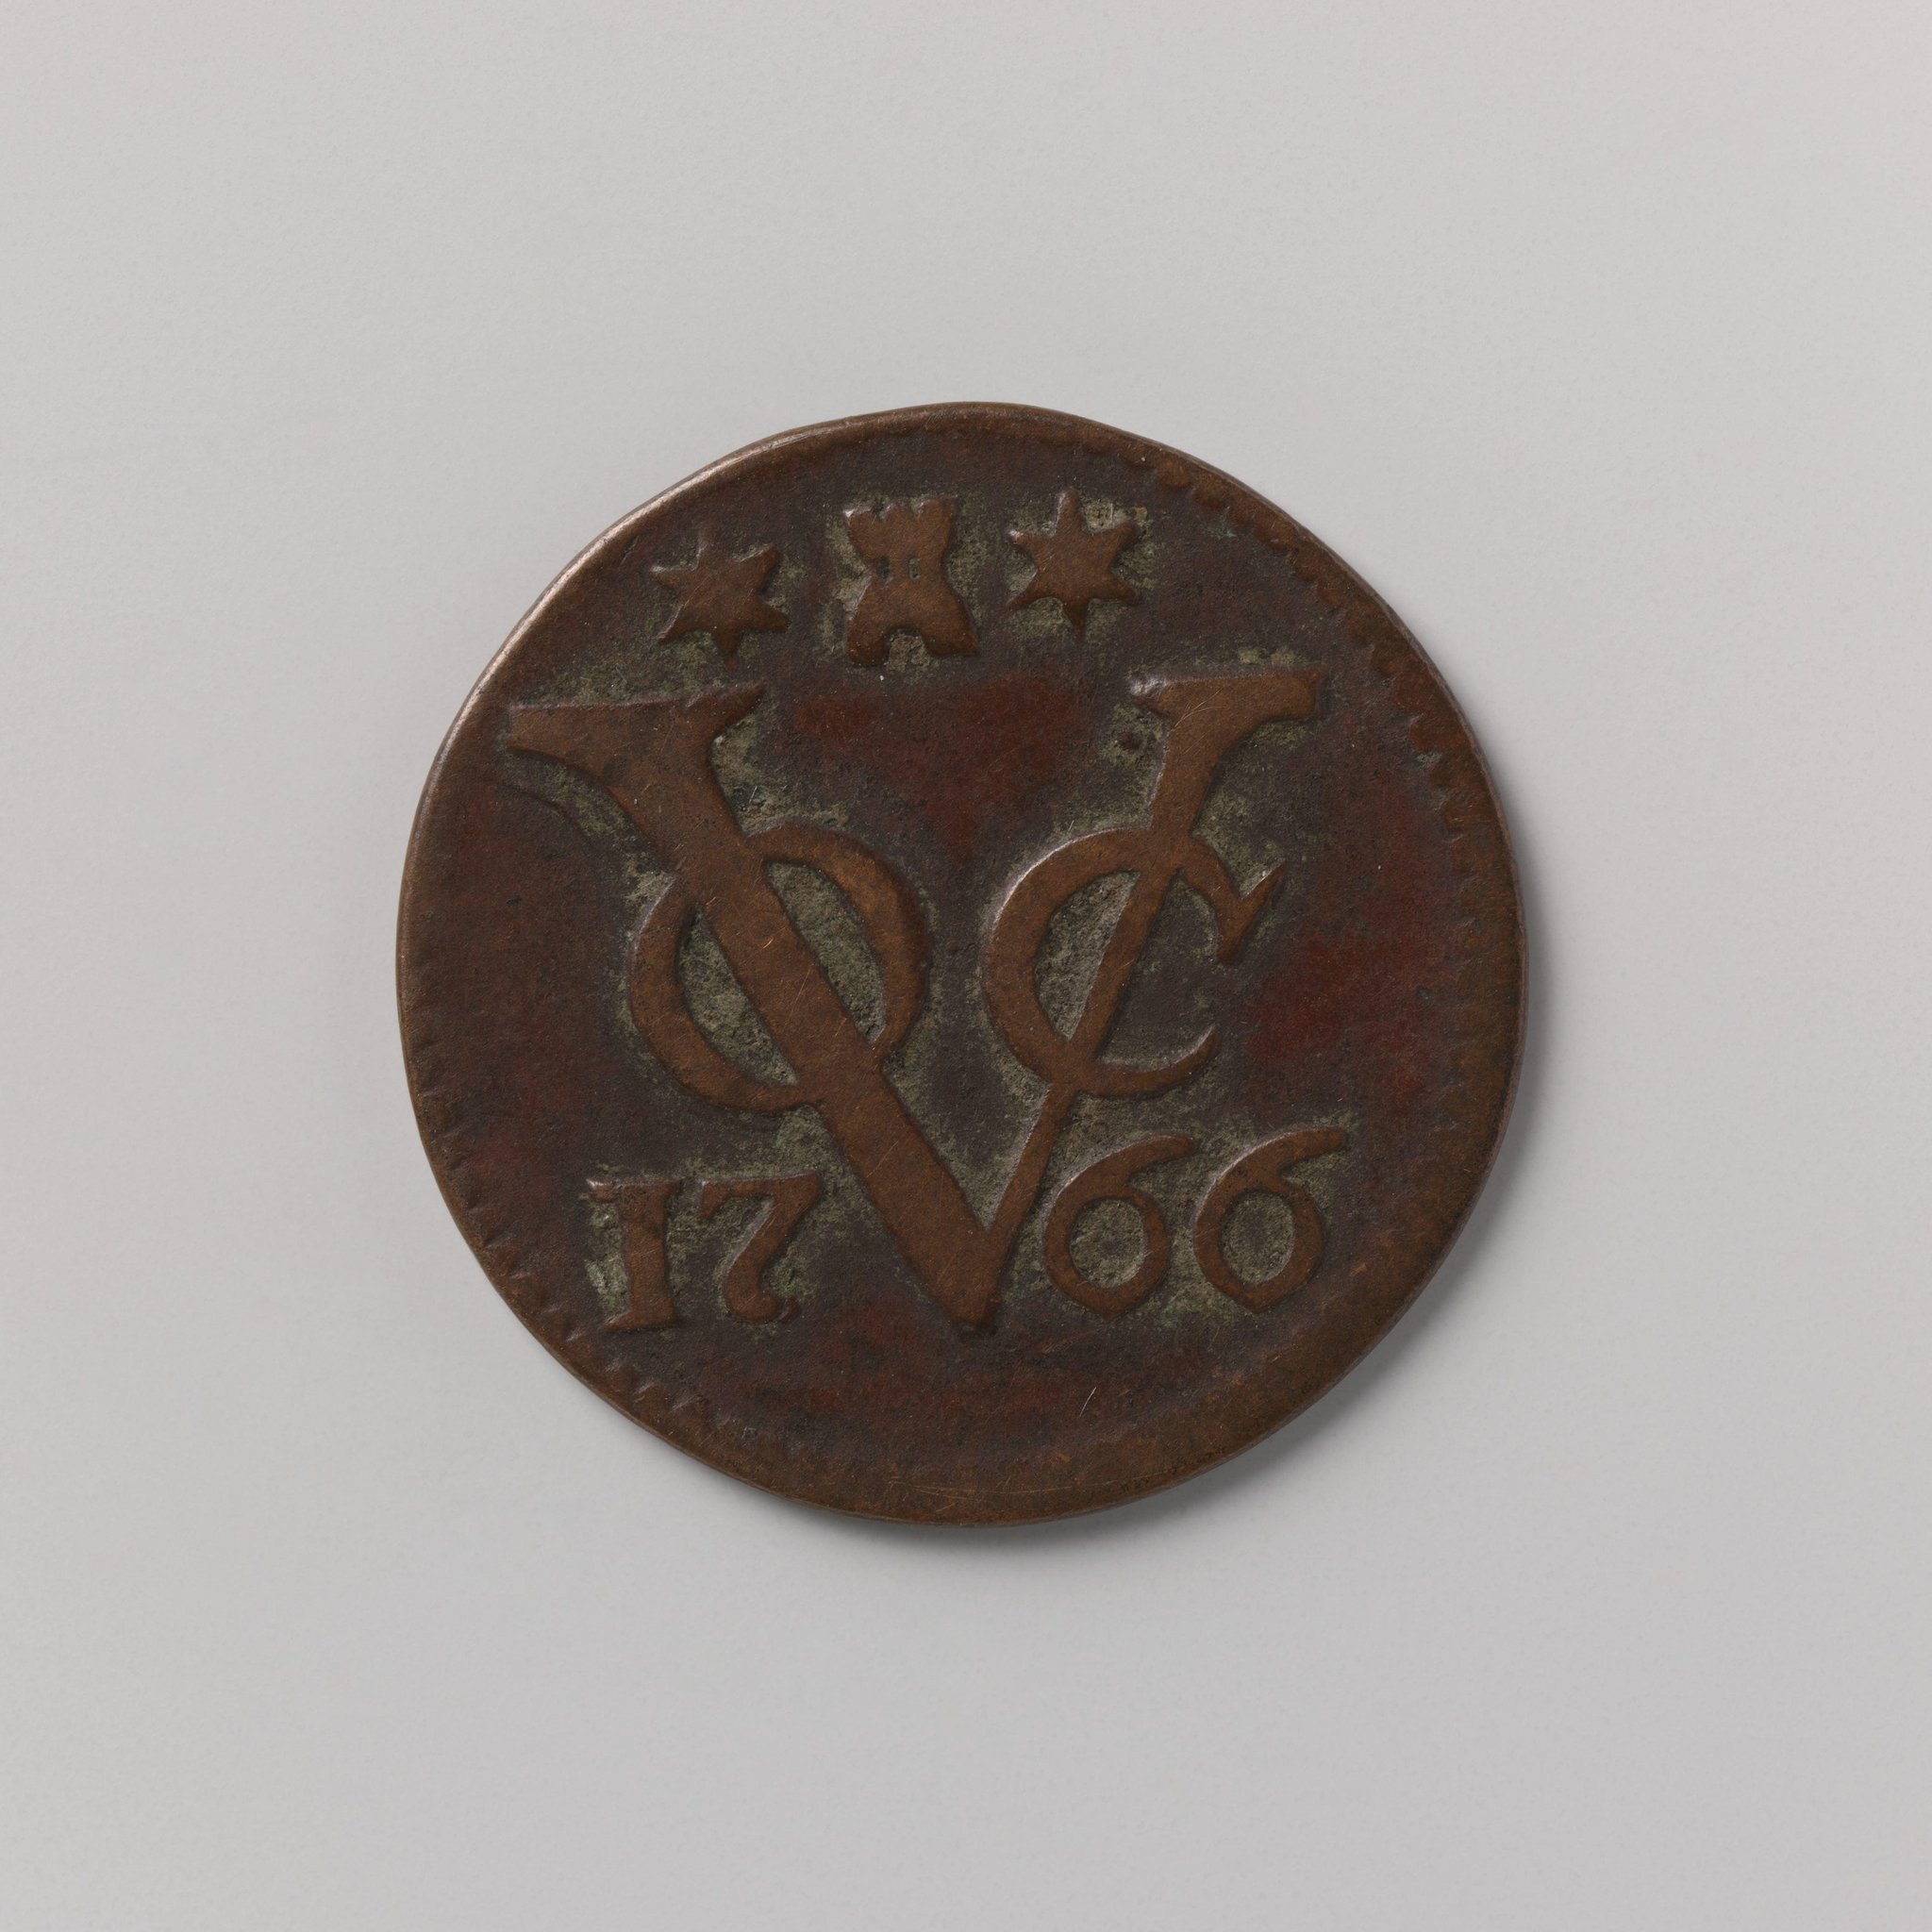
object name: coin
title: VOC, duit Zeeland, 1766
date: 1766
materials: copper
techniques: striking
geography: middelburg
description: Koperen munt. Voorzijde: gekroond wapenschild van Zeeland. Keerzijde: monogram van de VOC, waarboven muntteken en waaronder jaartal. Gladde rand.